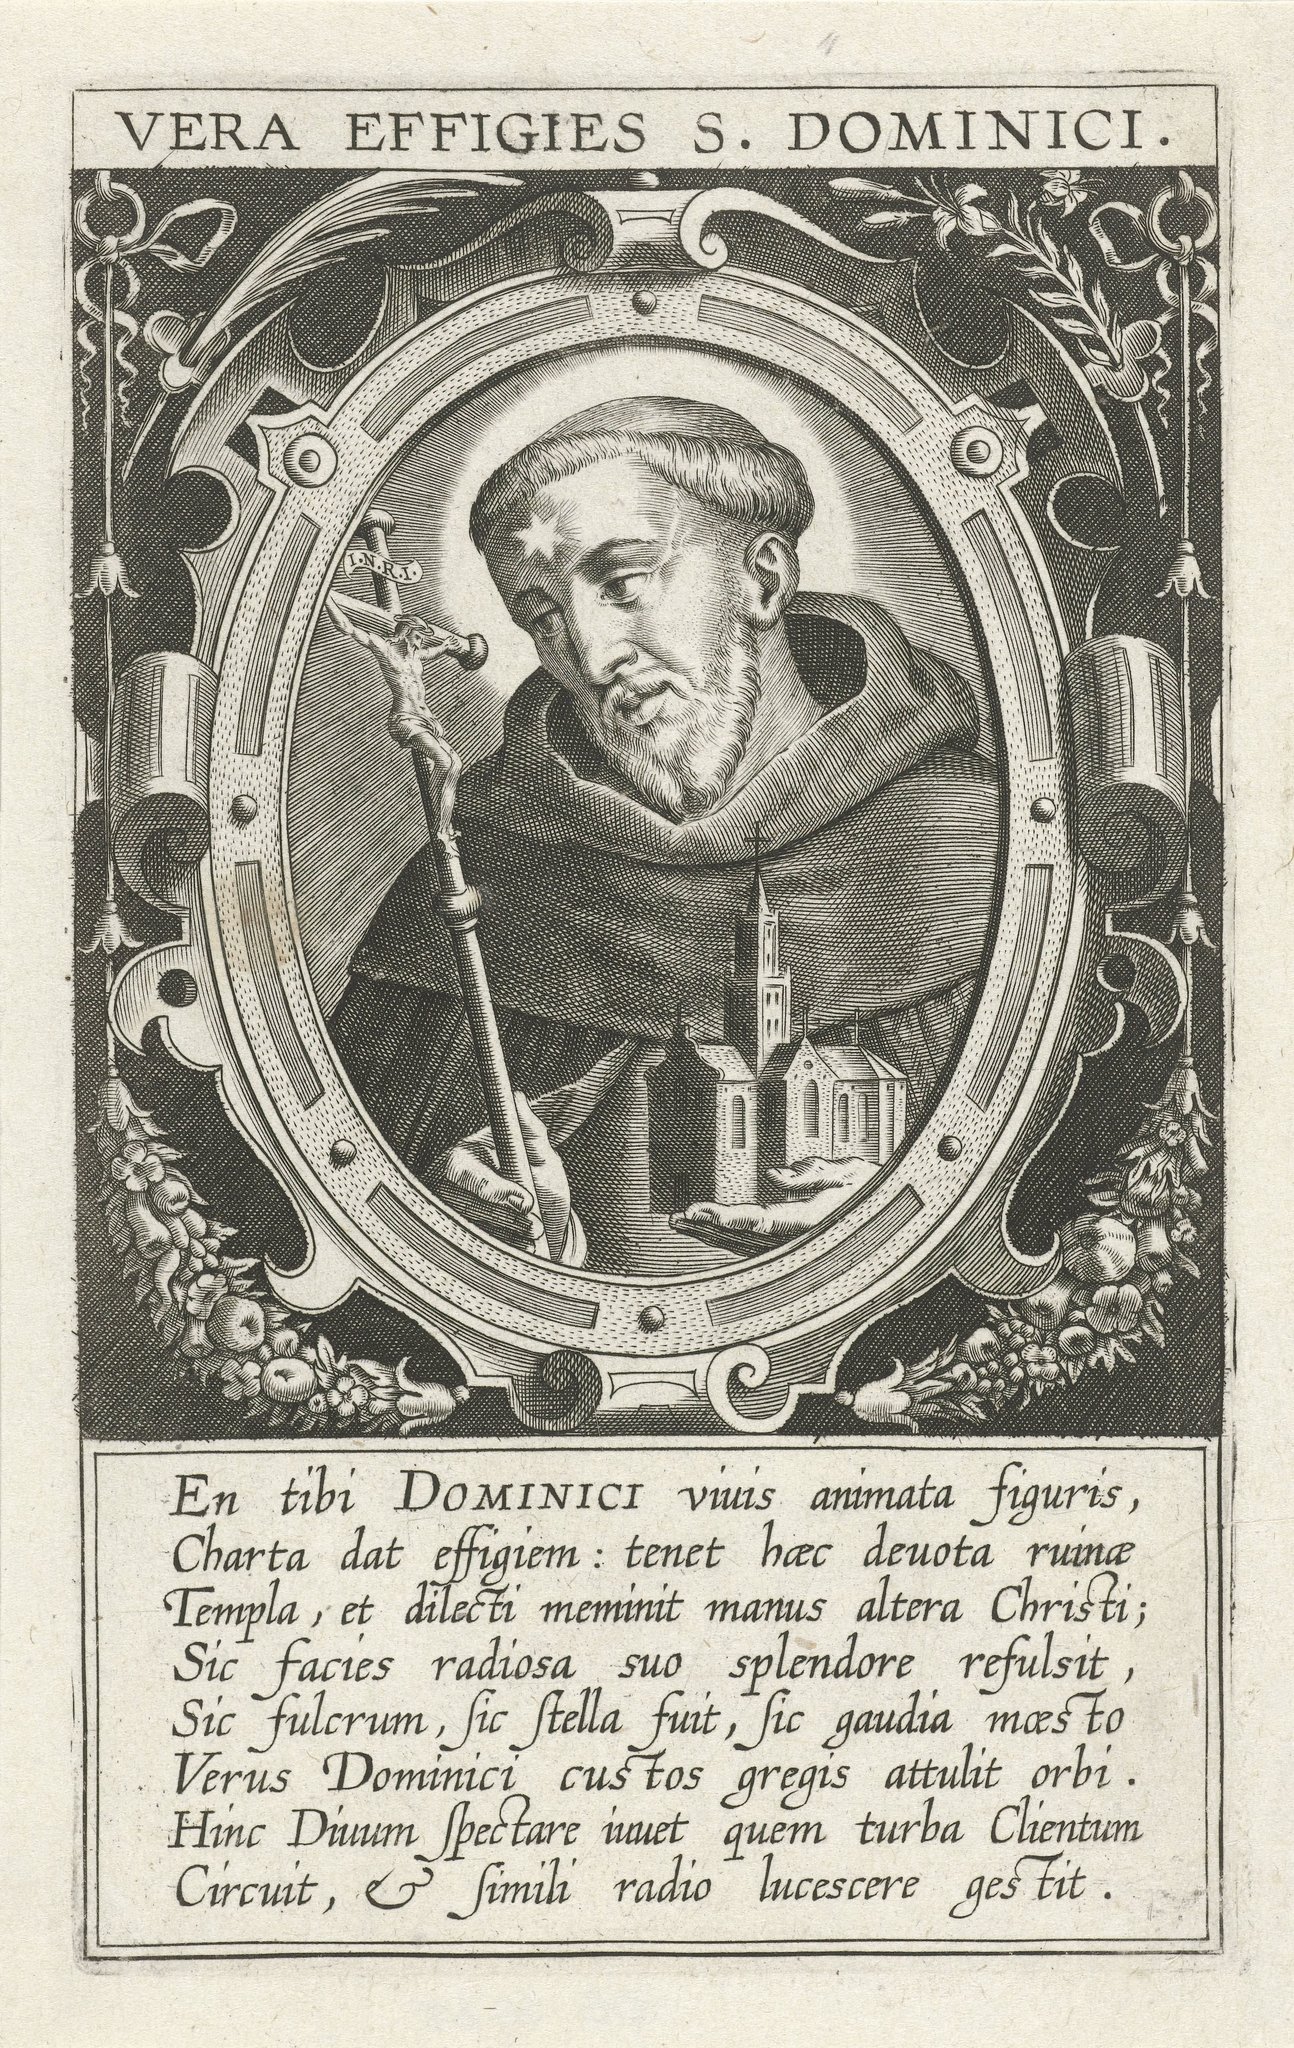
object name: book illustration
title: Portret van de Heilige Dominicus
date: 1611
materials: paper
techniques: engraving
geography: antwerp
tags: dominic(us) guzman of calerueja, founder of the order of preachers (or dominican (black) friars; possible attributes: book, dog with flaming torch, lily, loaf of bread, rosary, star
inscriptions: collector's mark: Lugt 2228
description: De heilige Dominicus, in ovale lijst. De prent heeft een Latijns onderschrift en is deel van een boek over het leven van de heilige Dominicus.